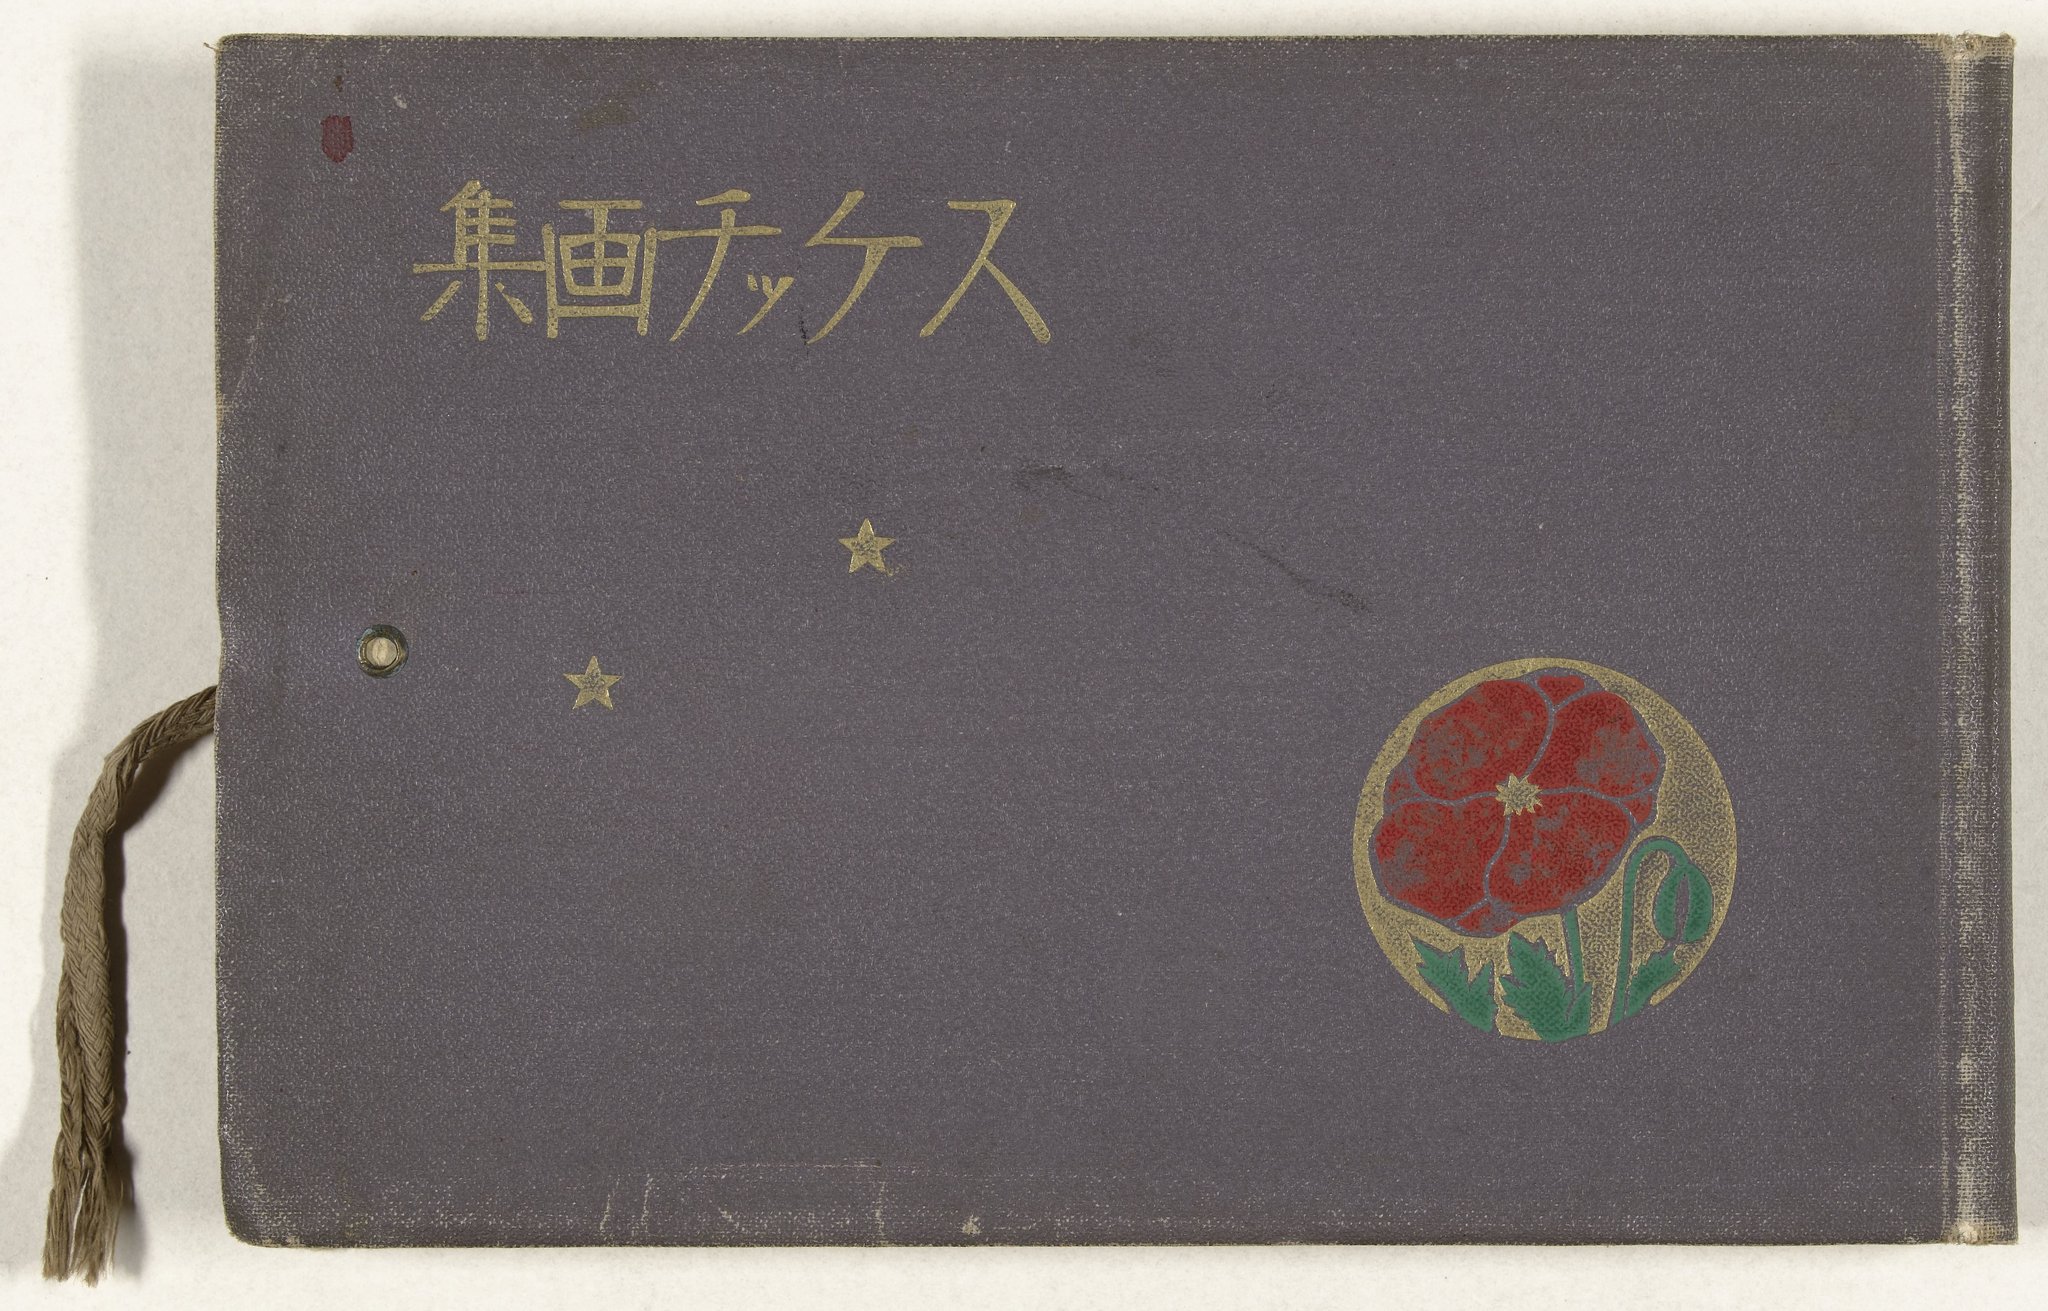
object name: book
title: Gedrukte schetsen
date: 1910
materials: paper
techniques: letterpress printing, lithograph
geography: japan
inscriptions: date